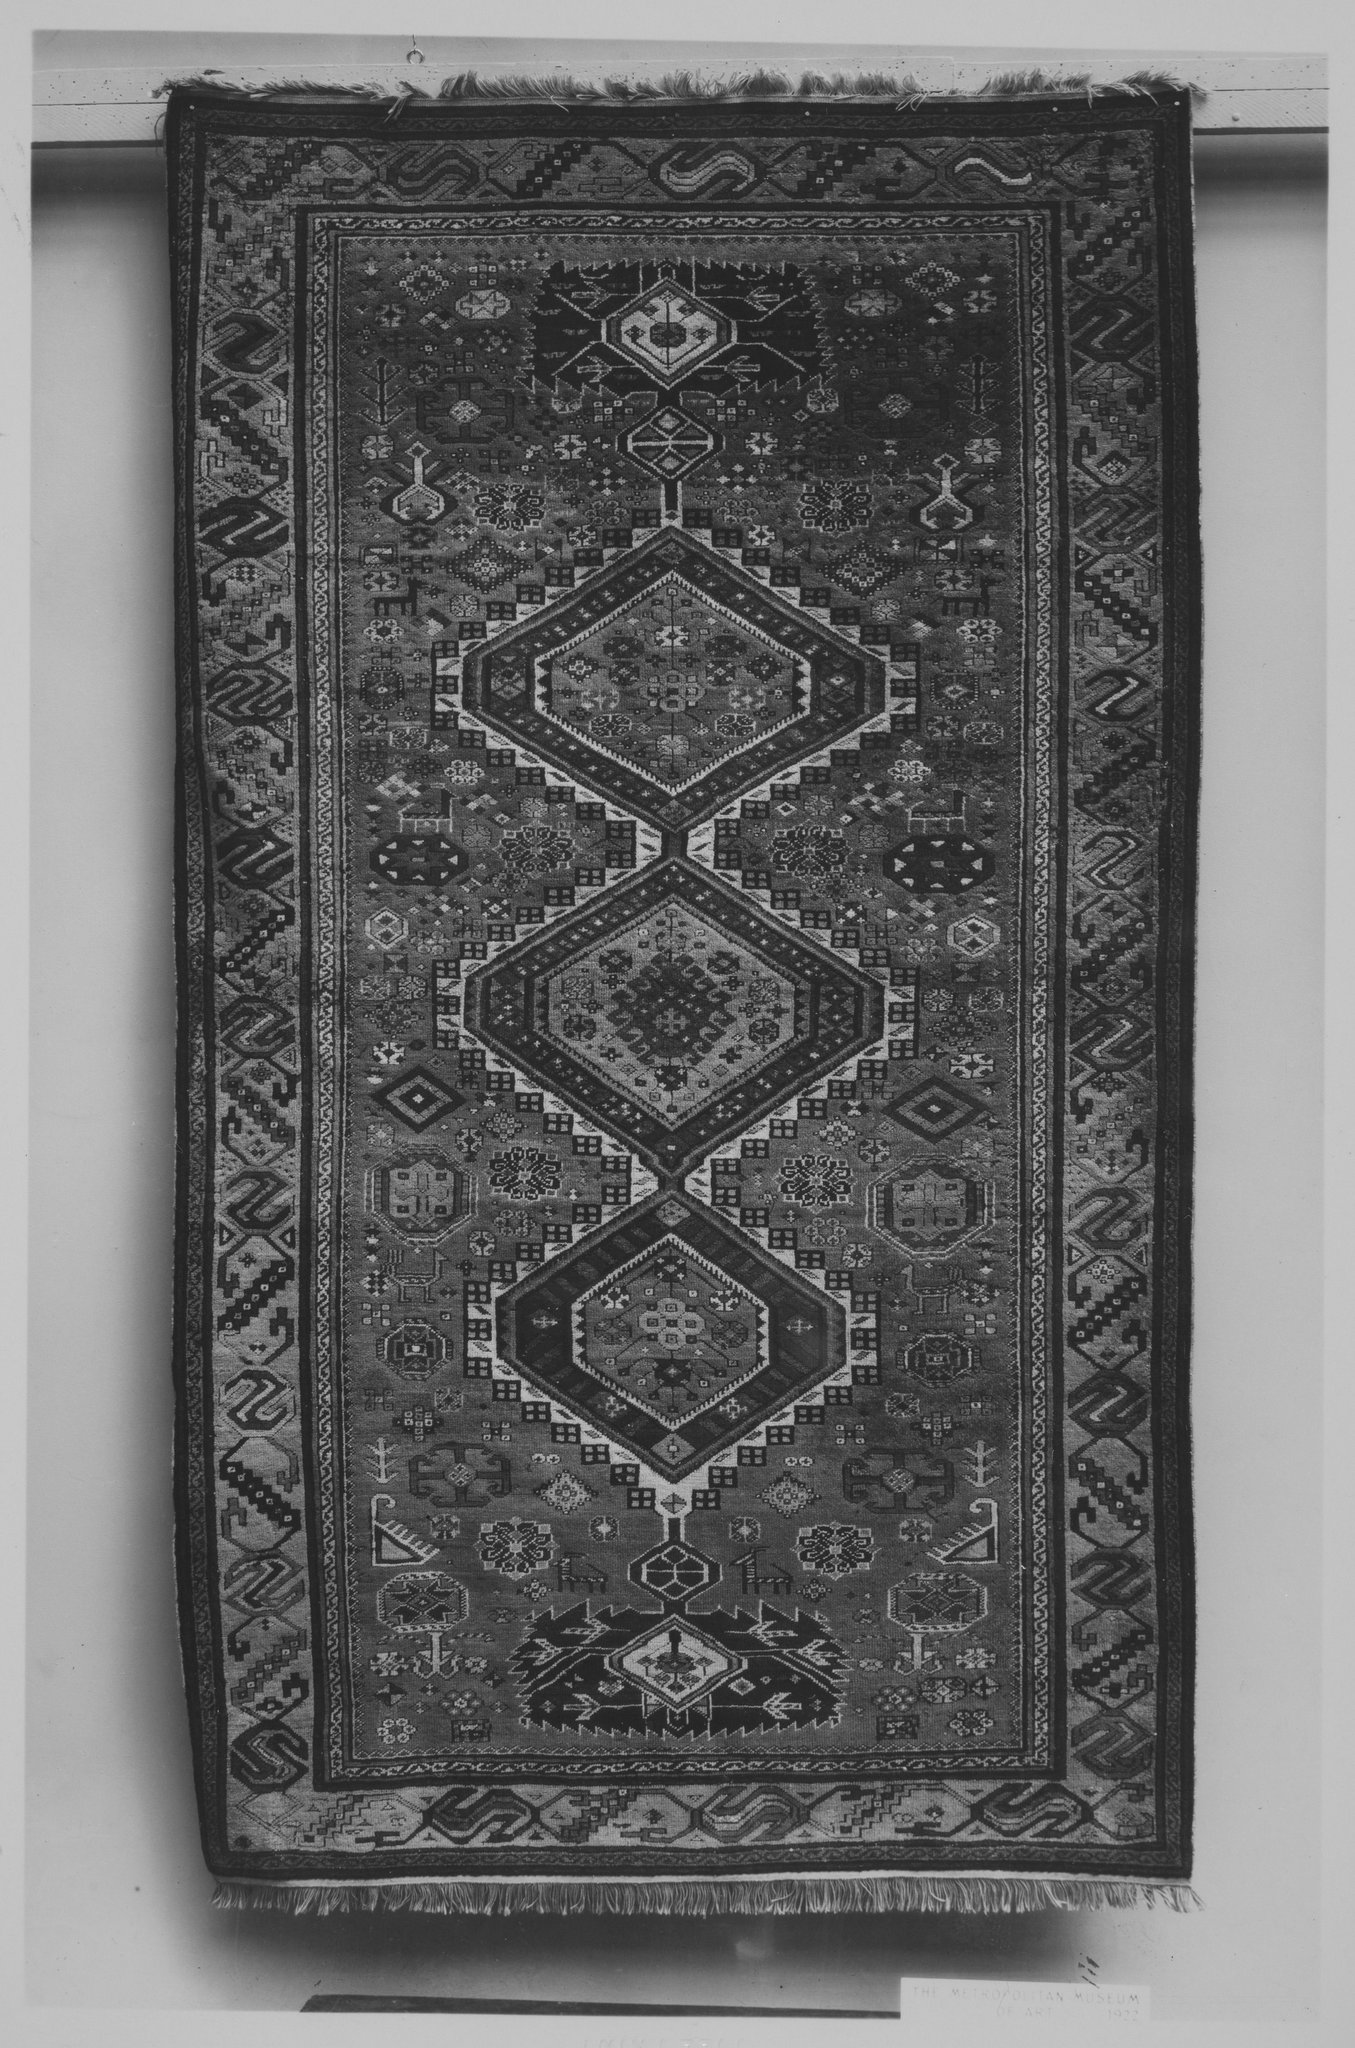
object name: carpet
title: Carpet with Triple Lozenge-Medallion Design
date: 1867-1900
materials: wool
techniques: pile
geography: azerbaijan